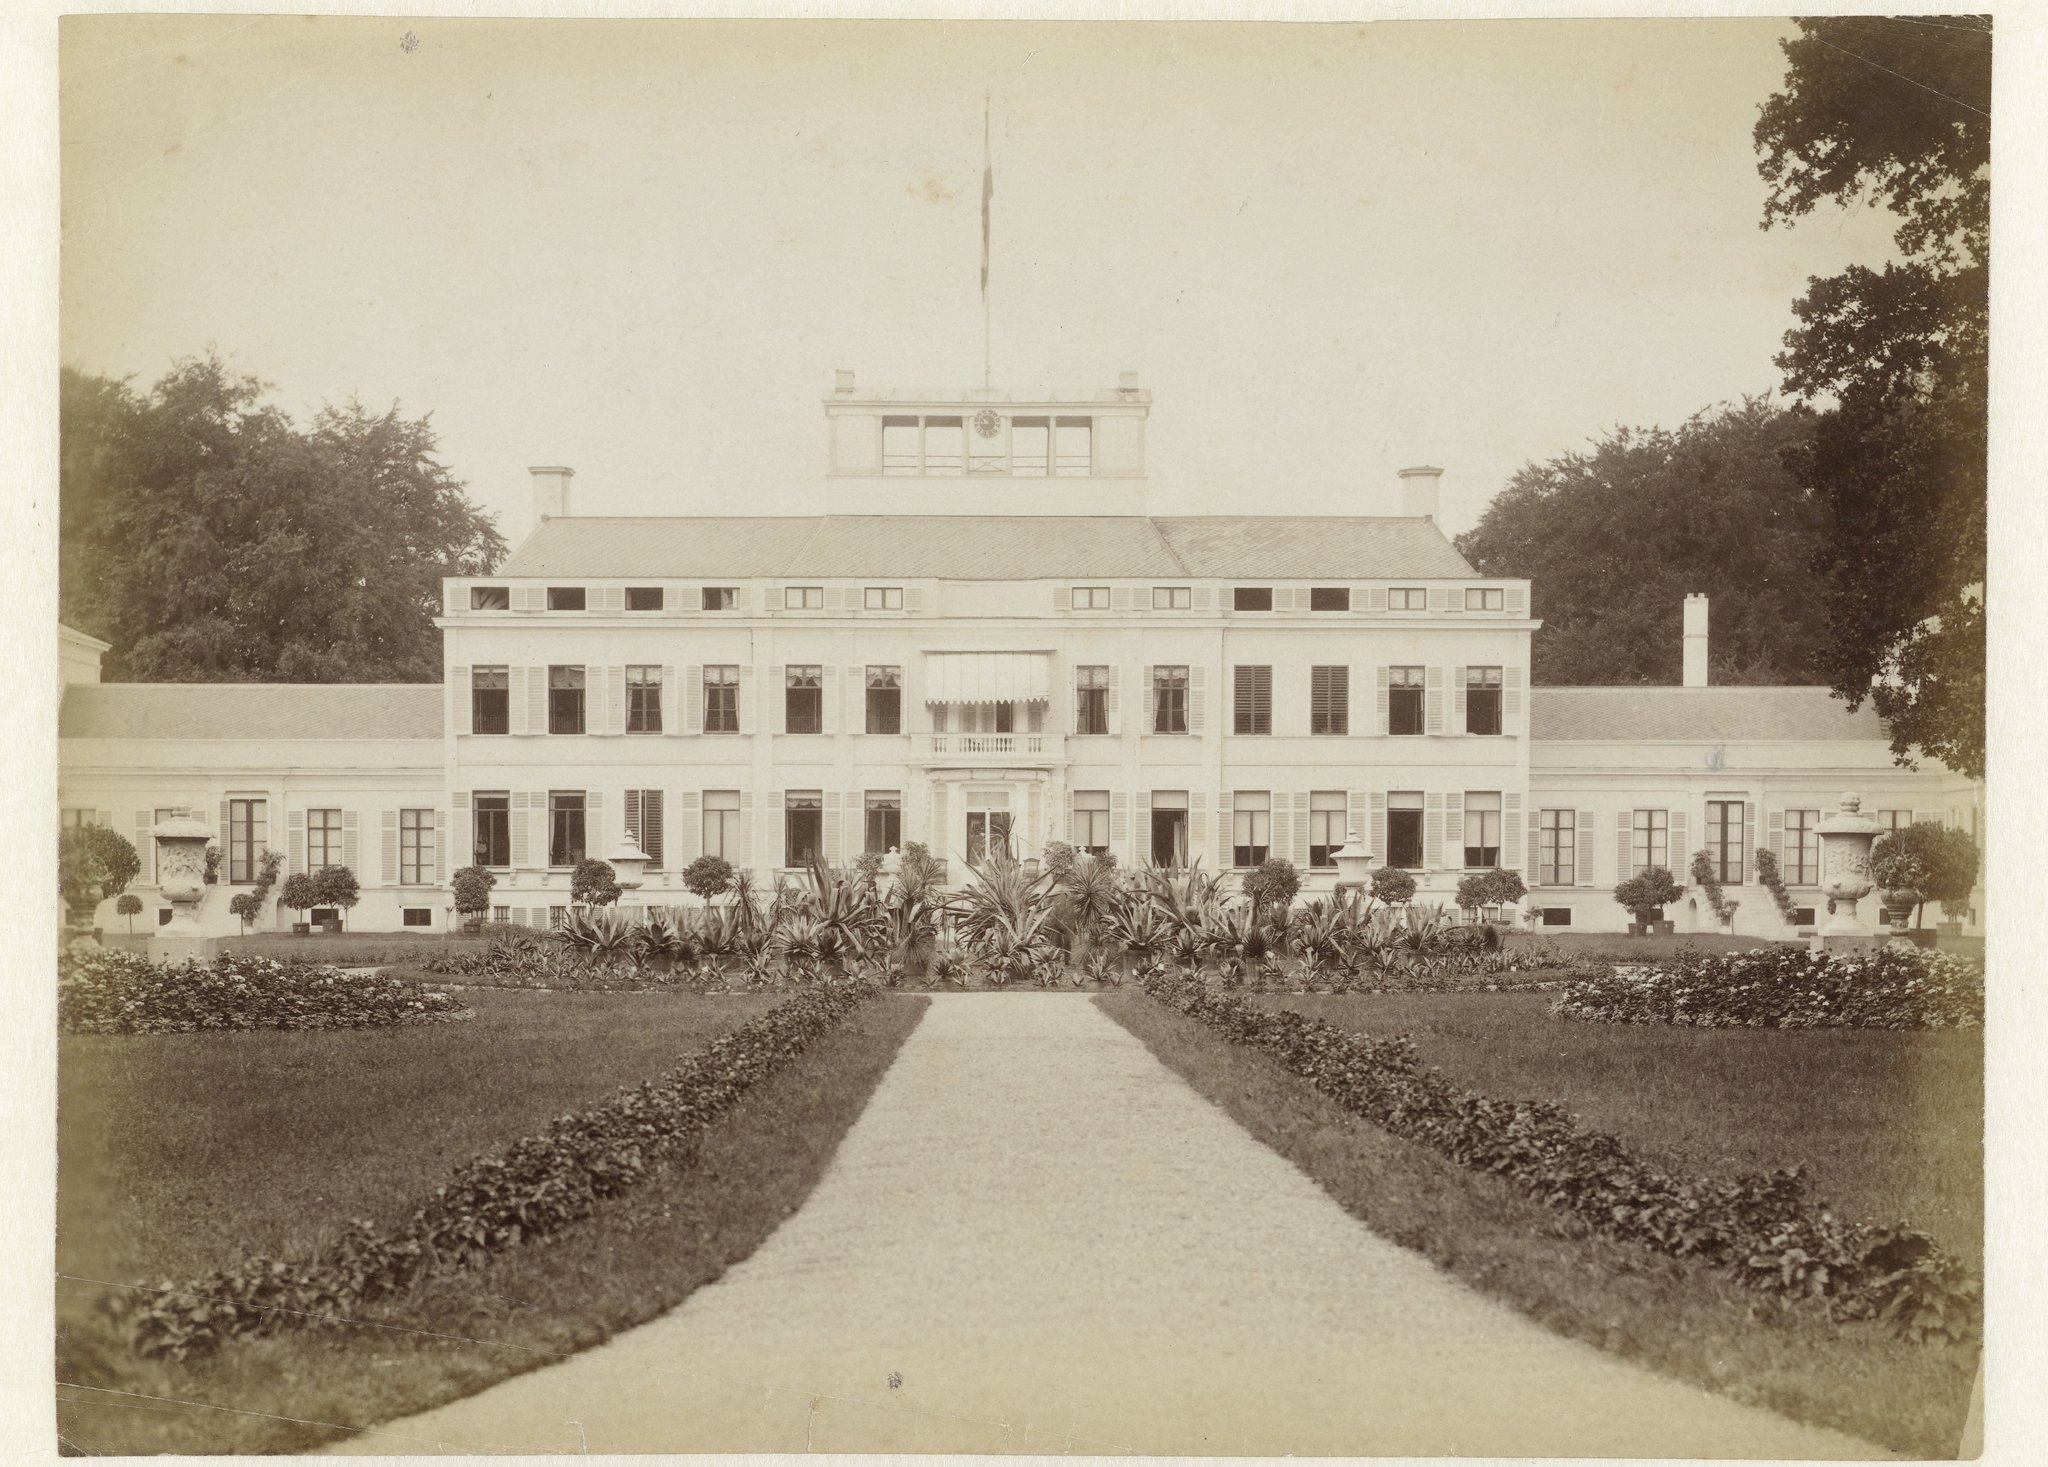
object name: photograph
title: Soestdijk 1895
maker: Anonymous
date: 1895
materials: paper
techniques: albumen print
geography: paris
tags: palace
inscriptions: inscription: ‘Soestdijk ±1895’, number: ‘150’